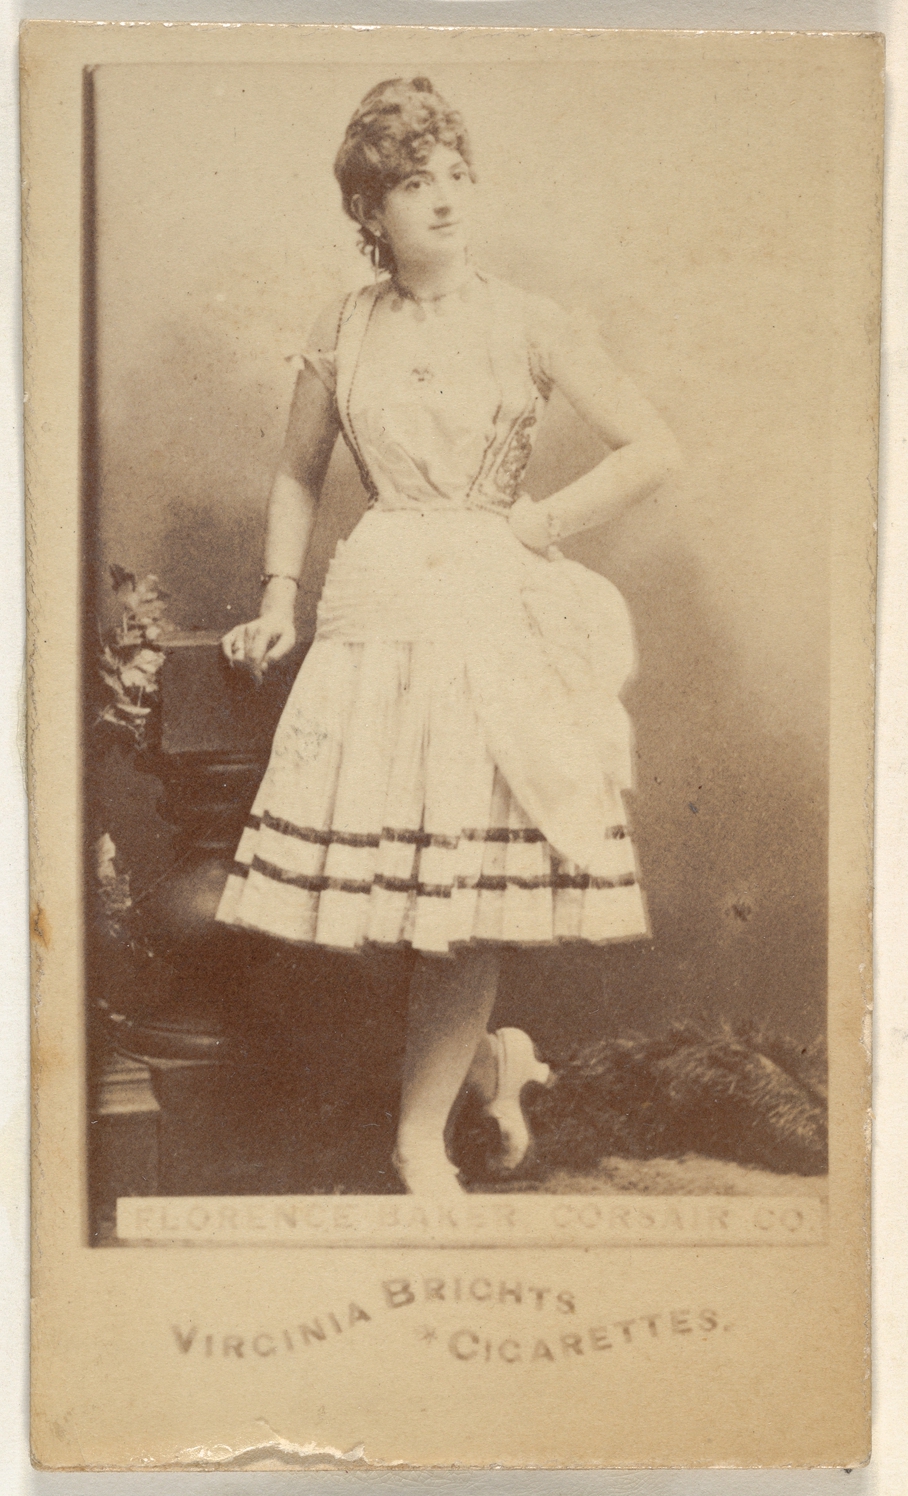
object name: photograph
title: Florence Baker, Corsair Co., from the Actors and Actresses series (N45, Type 6) for Virginia Brights Cigarettes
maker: allen & ginter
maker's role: publisher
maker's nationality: american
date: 1888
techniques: albumen silver print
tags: portraits,women,actresses